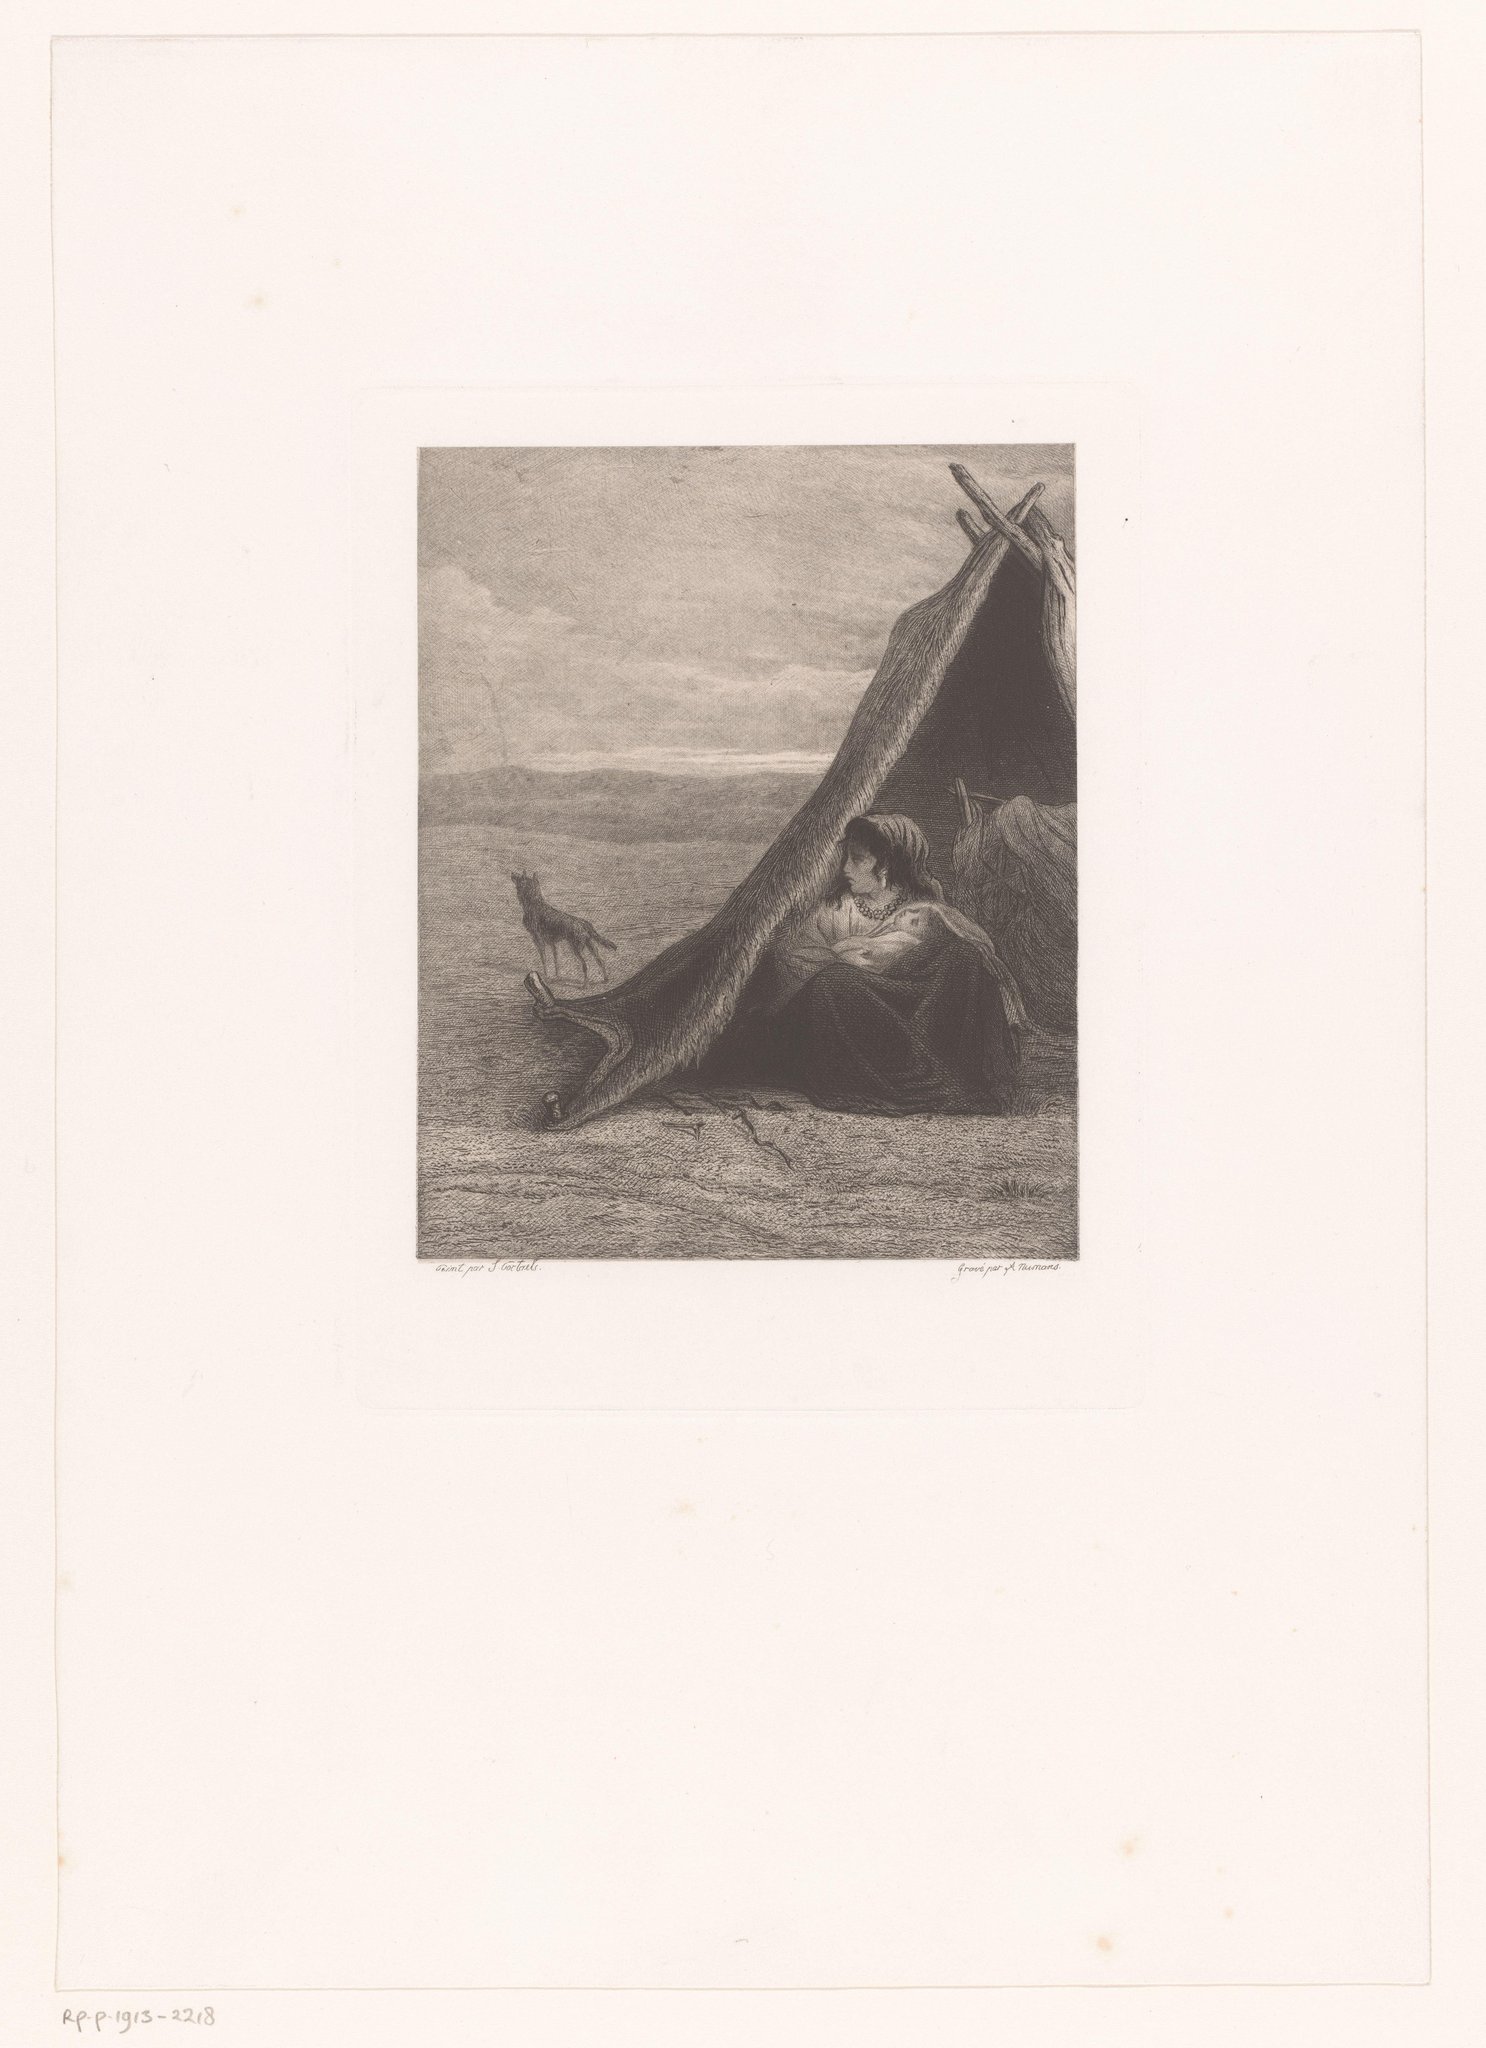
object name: print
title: Roma vrouw met baby gezeten onder een tent kijkt naar een blaffende hond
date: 1833-1879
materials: paper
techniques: etching, intaglio, roulette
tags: tent, wandering communities: romani or roma, mother and baby or young child, dog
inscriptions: collector's mark: Lugt 2228